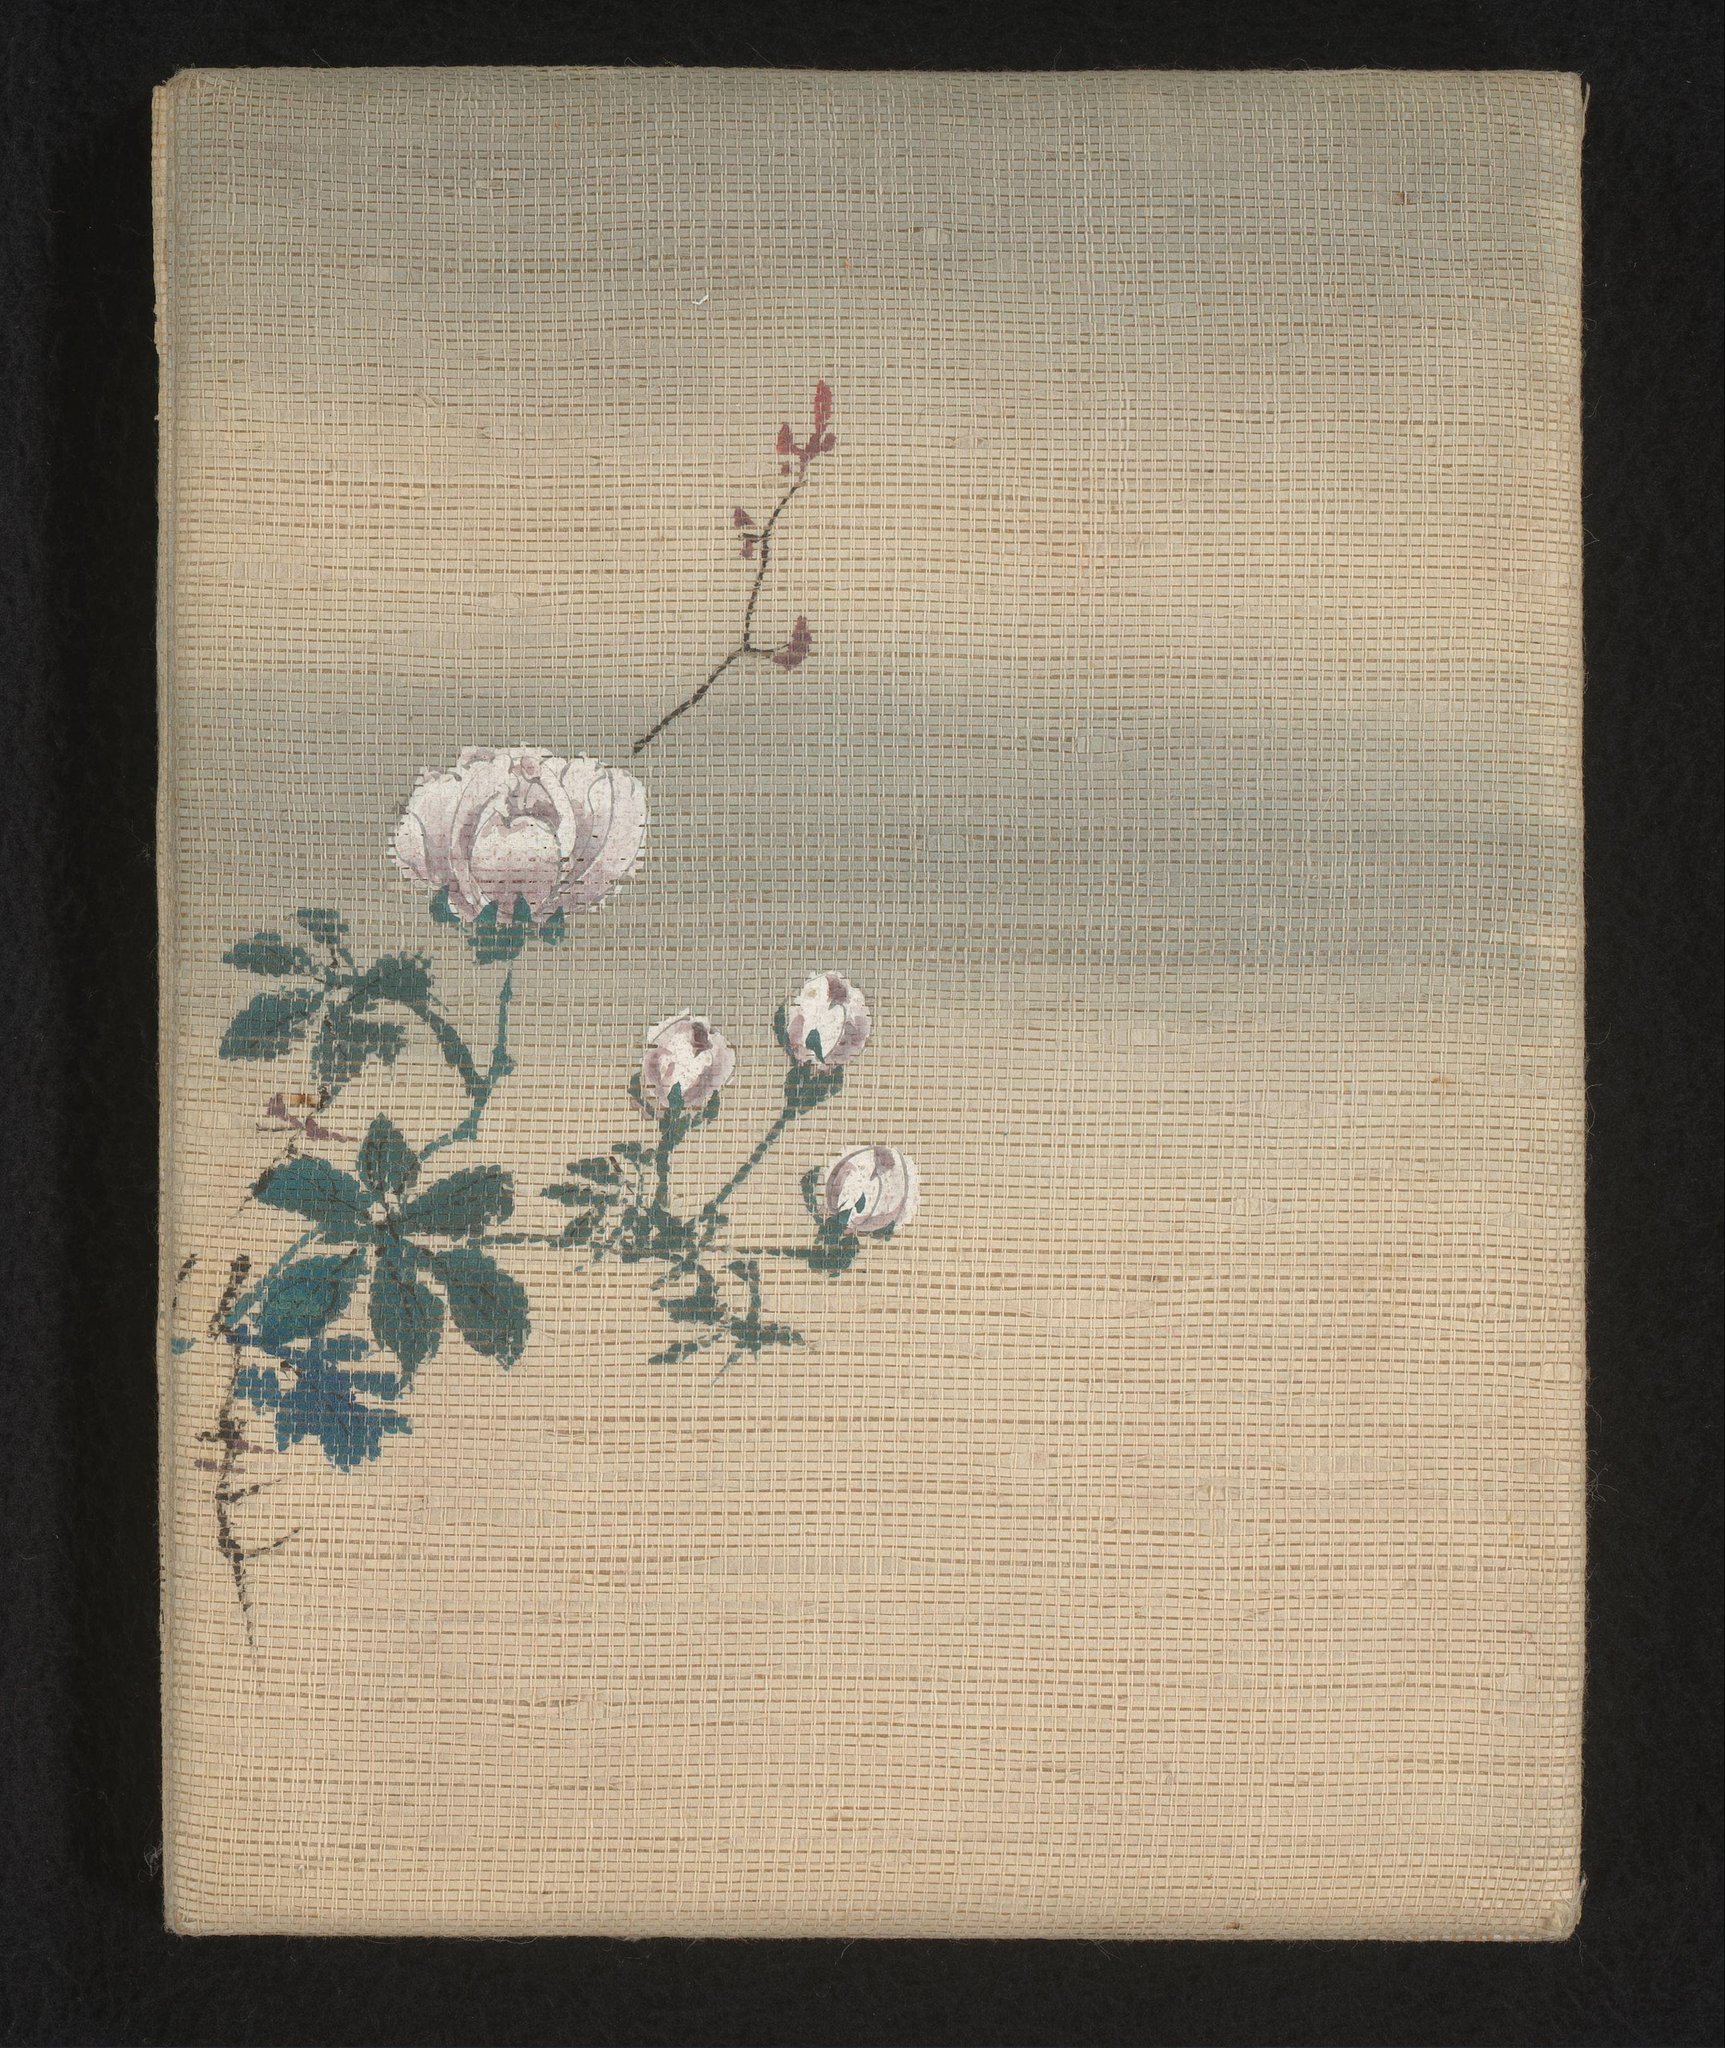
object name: slip in album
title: Fotoalbum (leeg)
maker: Anonymous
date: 1860-1900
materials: cardboard, paint, textile, wood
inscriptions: collector's mark: ‘DIENST/ VERSPREIDE/ RIJKSKOLLEKTIES/ (...) A 725’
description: Fotoalbum in de vorm van een leporello met vier passe-partouts voor een kabinetfoto.